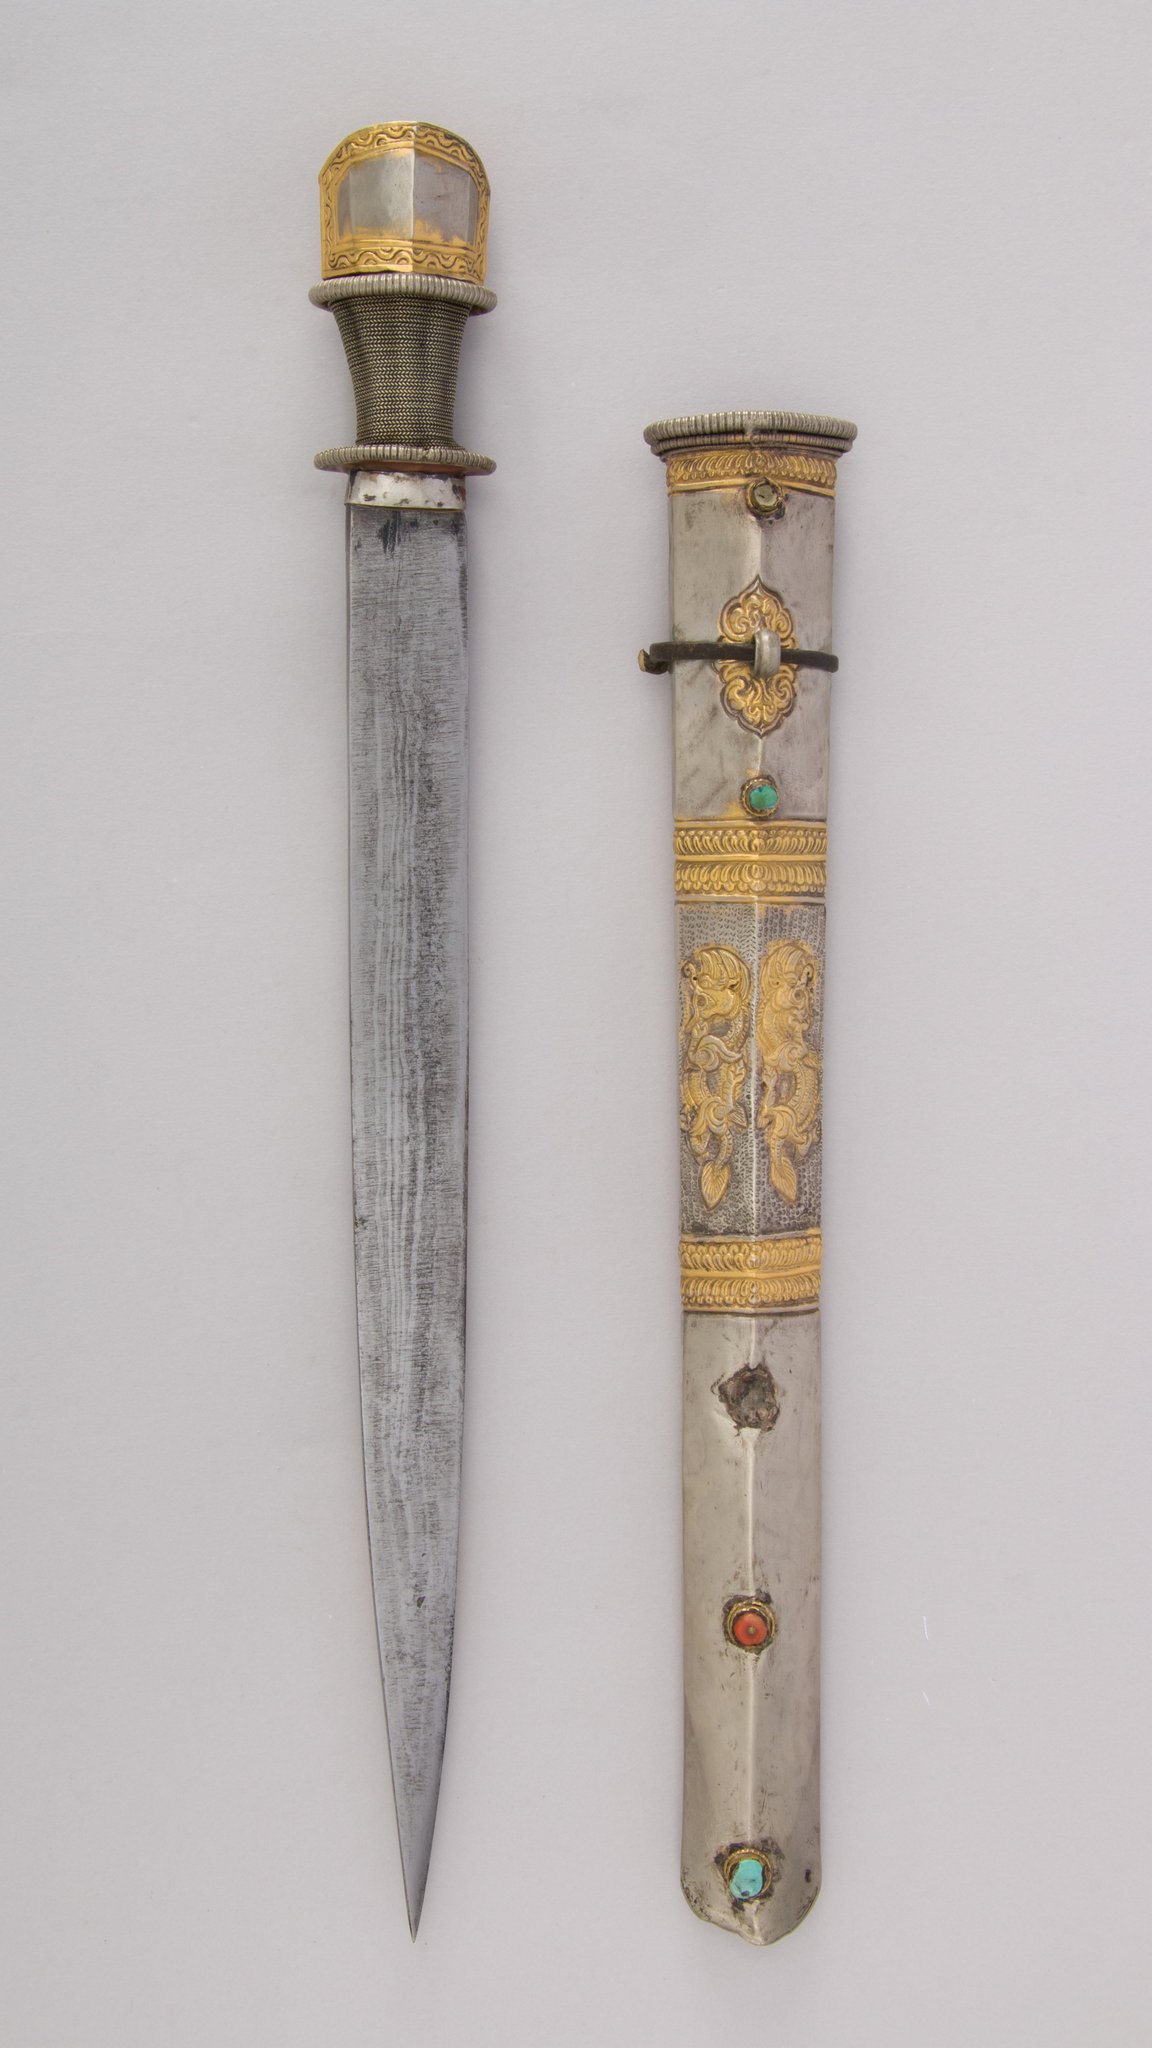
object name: dagger with sheath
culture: bhutanese or sikkimese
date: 1801-1900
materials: coral, gold, silver, steel, metal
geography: bhutan